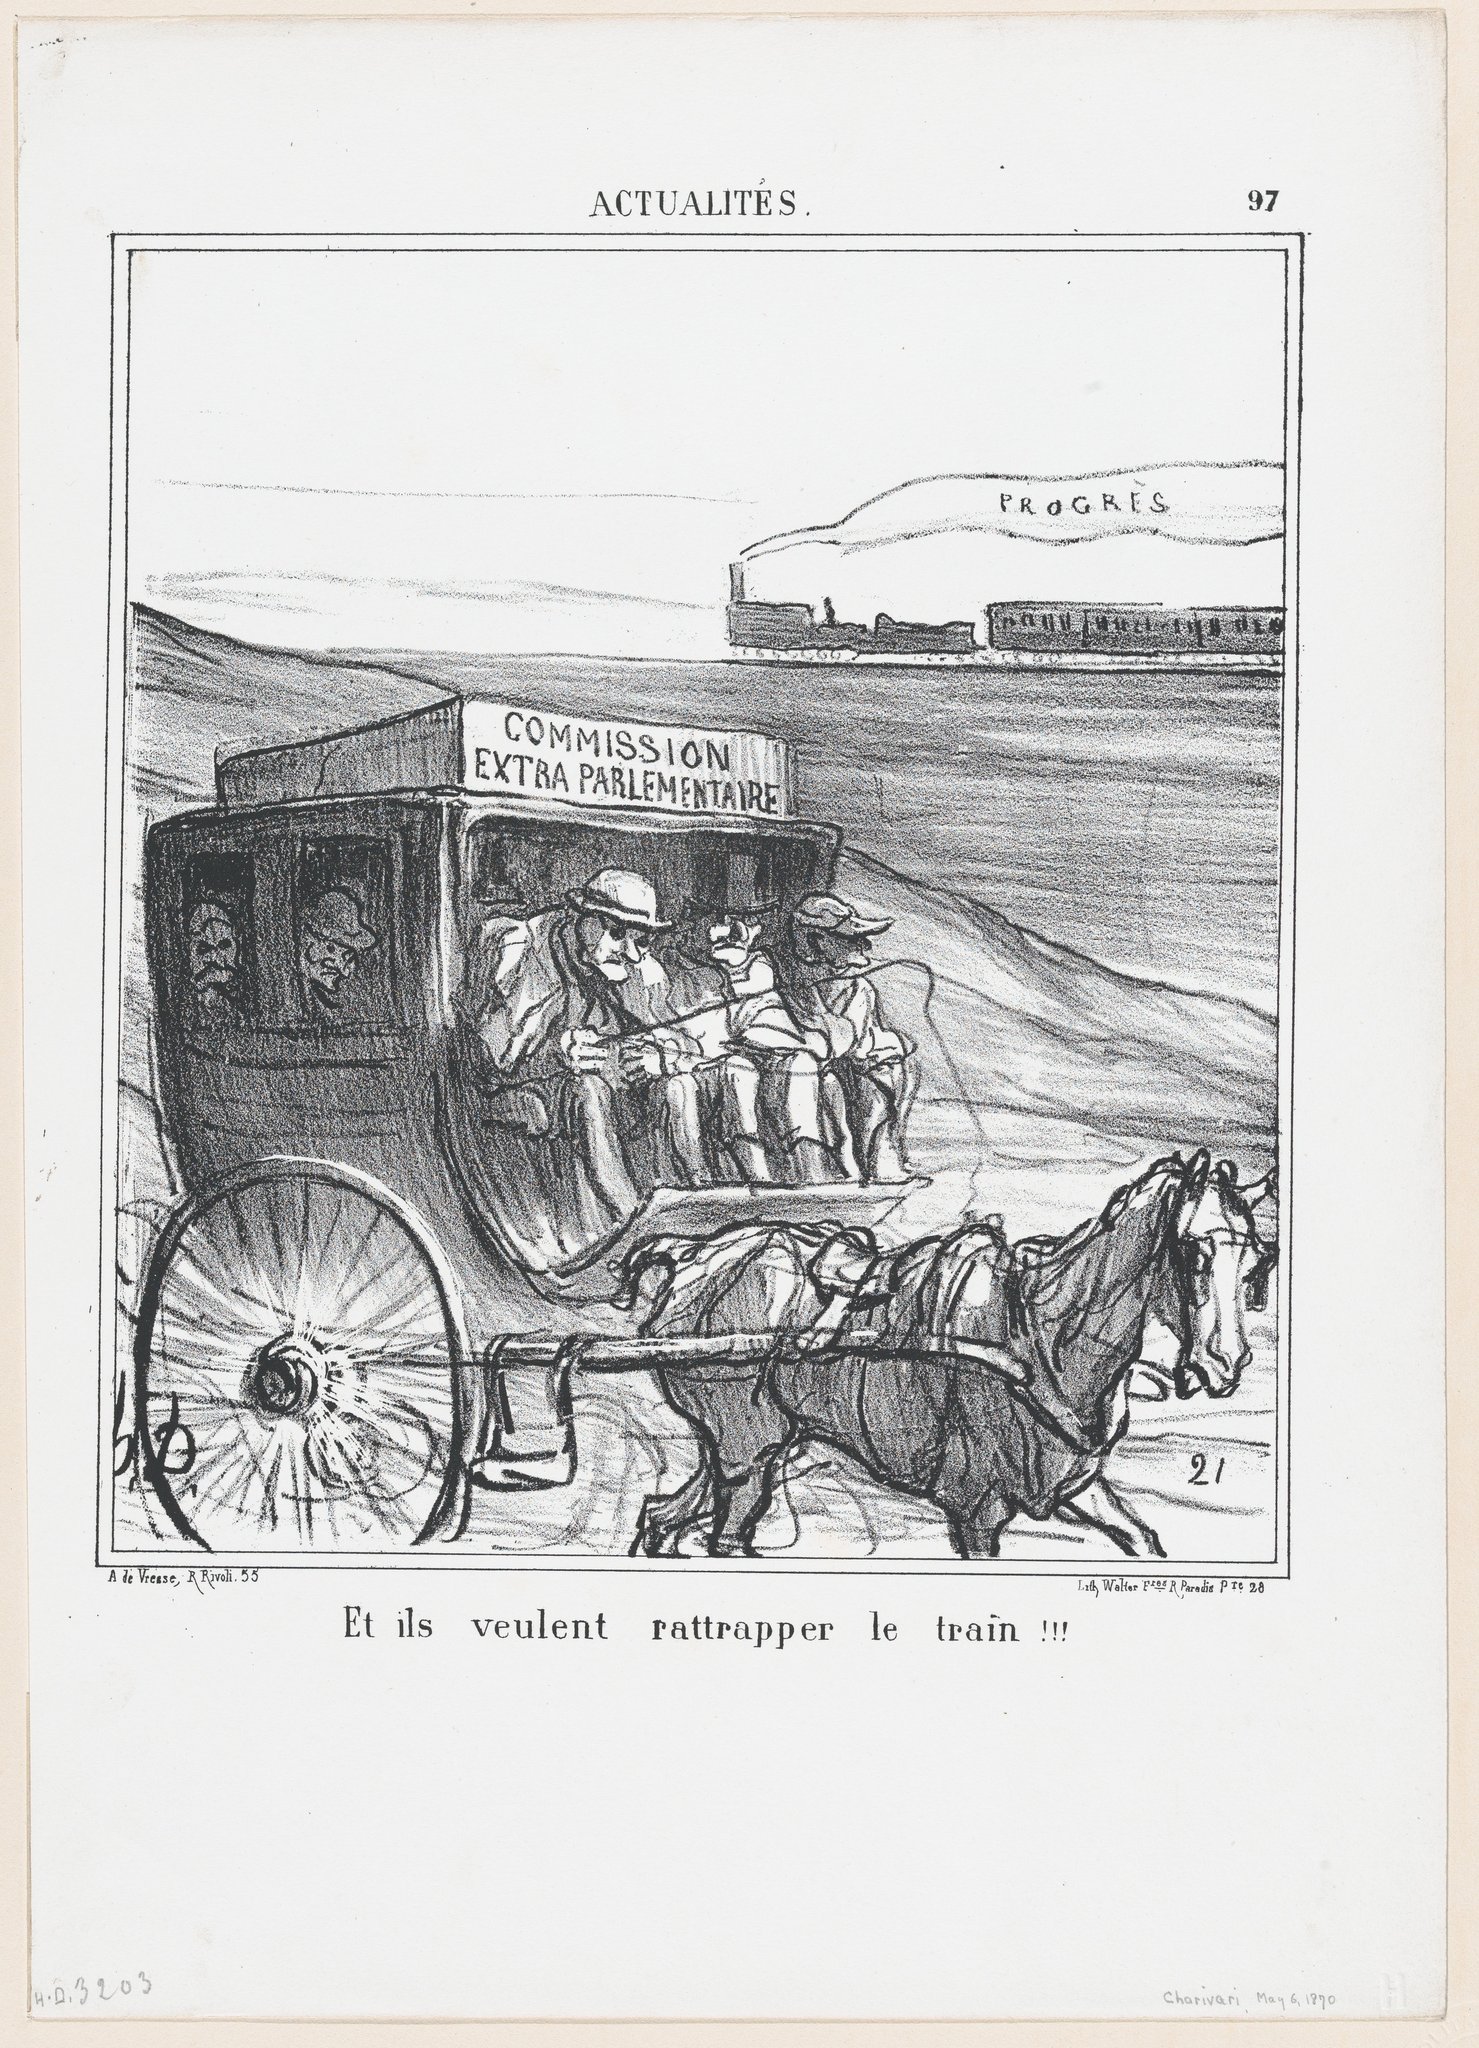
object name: print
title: They think they might be able to overtake the train!!!, from 'News of the day,' published in "Le Charivari"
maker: honoré daumier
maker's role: artist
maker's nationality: french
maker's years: 1808-1879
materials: paper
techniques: lithograph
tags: railways,men,carriages,trains